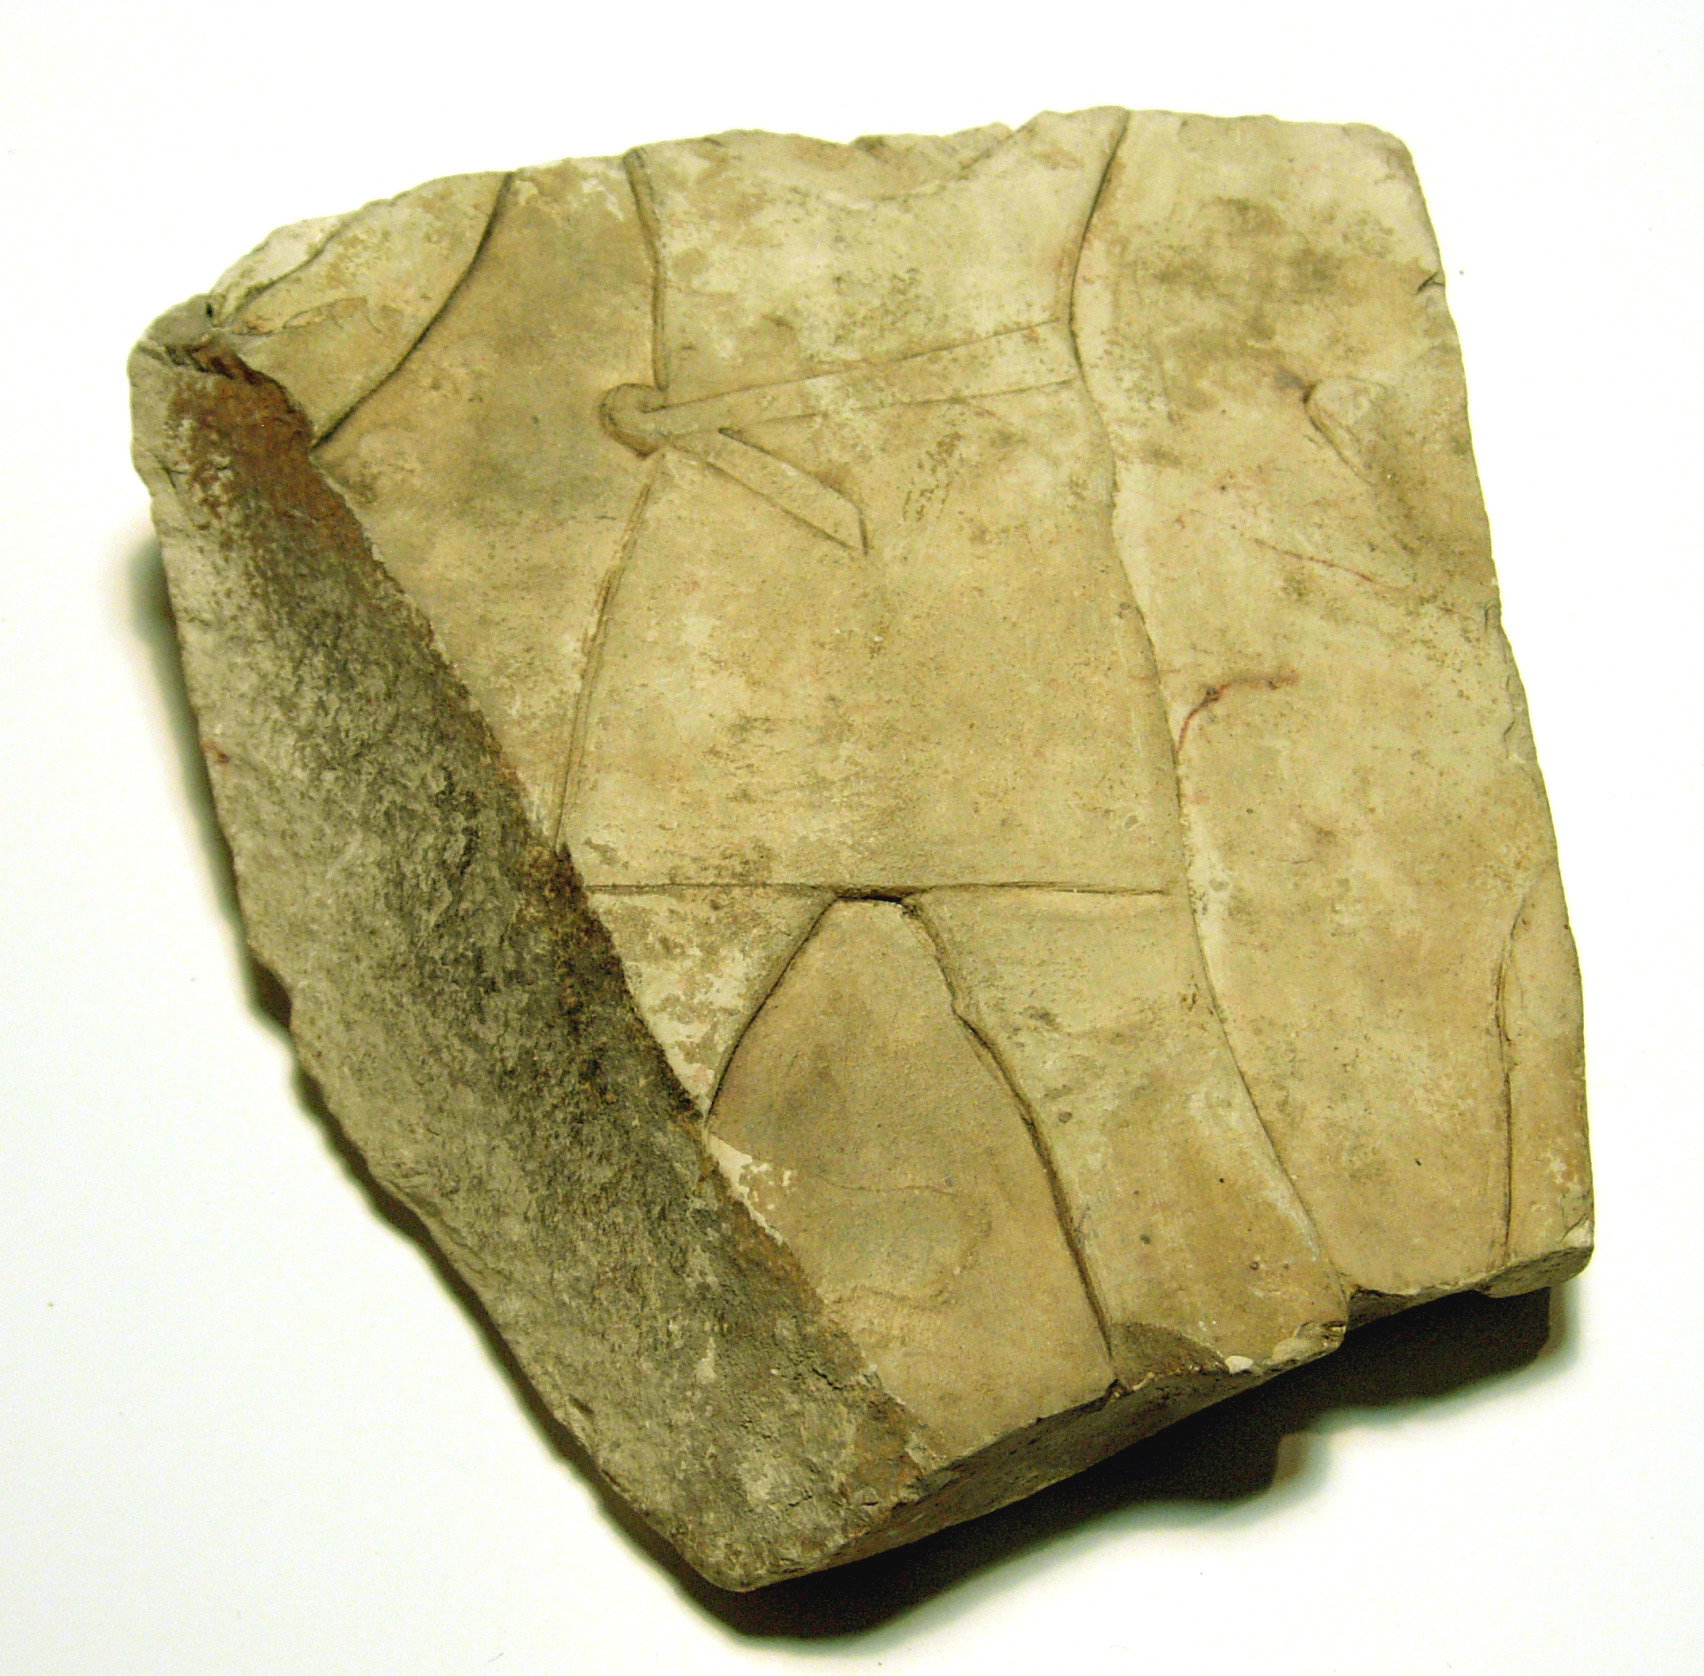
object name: relief, tomb of nespekashuty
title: Raised relief fragment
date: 664-610 BCE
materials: limestone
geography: egypt